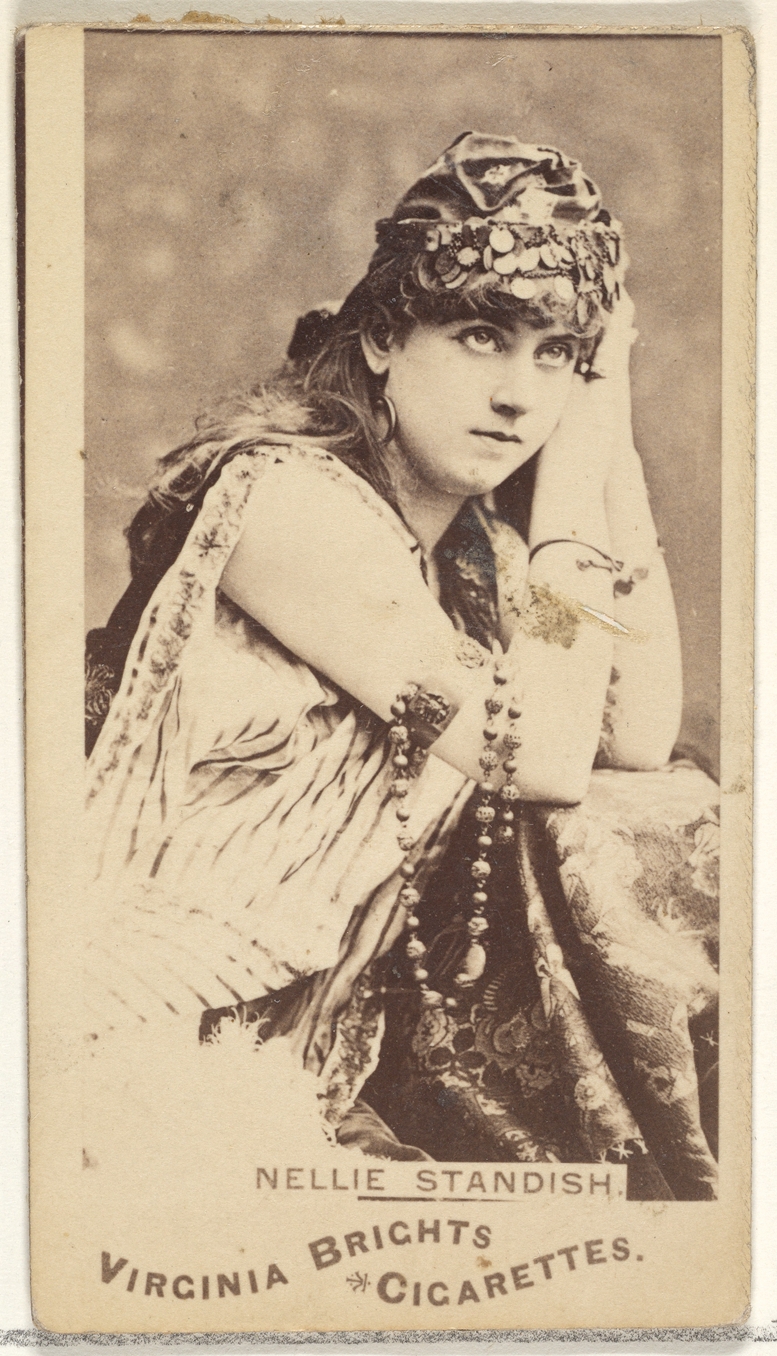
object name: photograph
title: Nellie Standish, from the Actors and Actresses series (N45, Type 1) for Virginia Brights Cigarettes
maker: allen & ginter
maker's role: publisher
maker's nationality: american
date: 1888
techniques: albumen silver print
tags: portraits,women,actresses